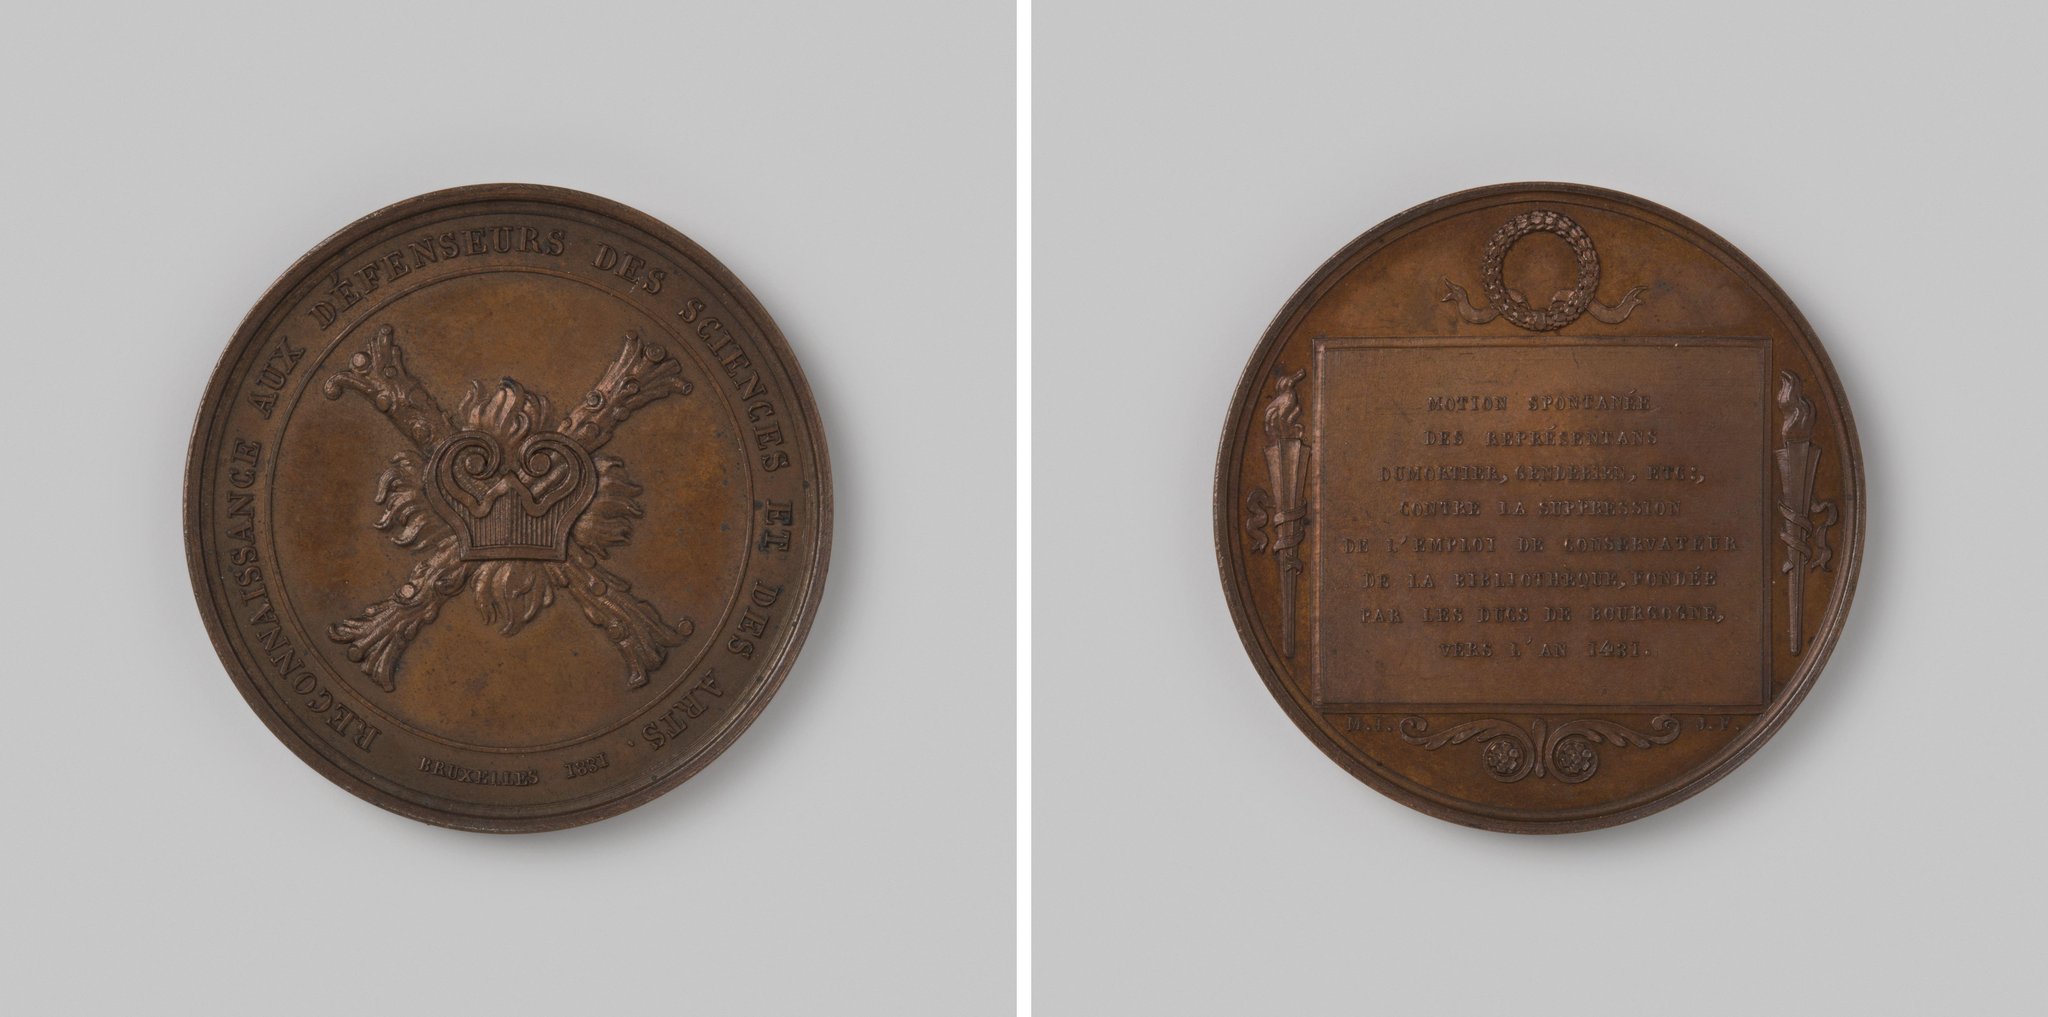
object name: history medal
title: Aannemen van motie om de opheffing van het conservatorschap van de bibliotheek van de hertogen van Bourgondië ongedaan te maken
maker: marchal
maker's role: designer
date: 1831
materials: bronze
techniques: striking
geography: brussels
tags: politician, brussels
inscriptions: inscription: ‘MOTION SPONTANÉE / DES REPRÉSENTANS / DUMORTIER, GENDEBIEN, ETC:, / CONTRE LA SUPPRESSION / DE L'EMPLOI DE CONSERVATEUR / DE LA BIBLIOTHÈQUE, FONDÉE / PAR LES DUCS DE BOURGOGNE, VERS L'AN 1431 .’, signature: ‘M . I . - J . F .’, circumscription: ‘RECONNAISSANCE AUX DÉFENSEURS DES SCIENCES ET DES ARTS . BRUXELLES 1831’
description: Bronzen penning. Voorzijde: Bourgondische vuurslag, waaruit vonken schieten op een Bourgondisch kruis binnen omschrift. Keerzijde: tableau met opschrift onder krans en geflankeerd door twee brandende fakkels